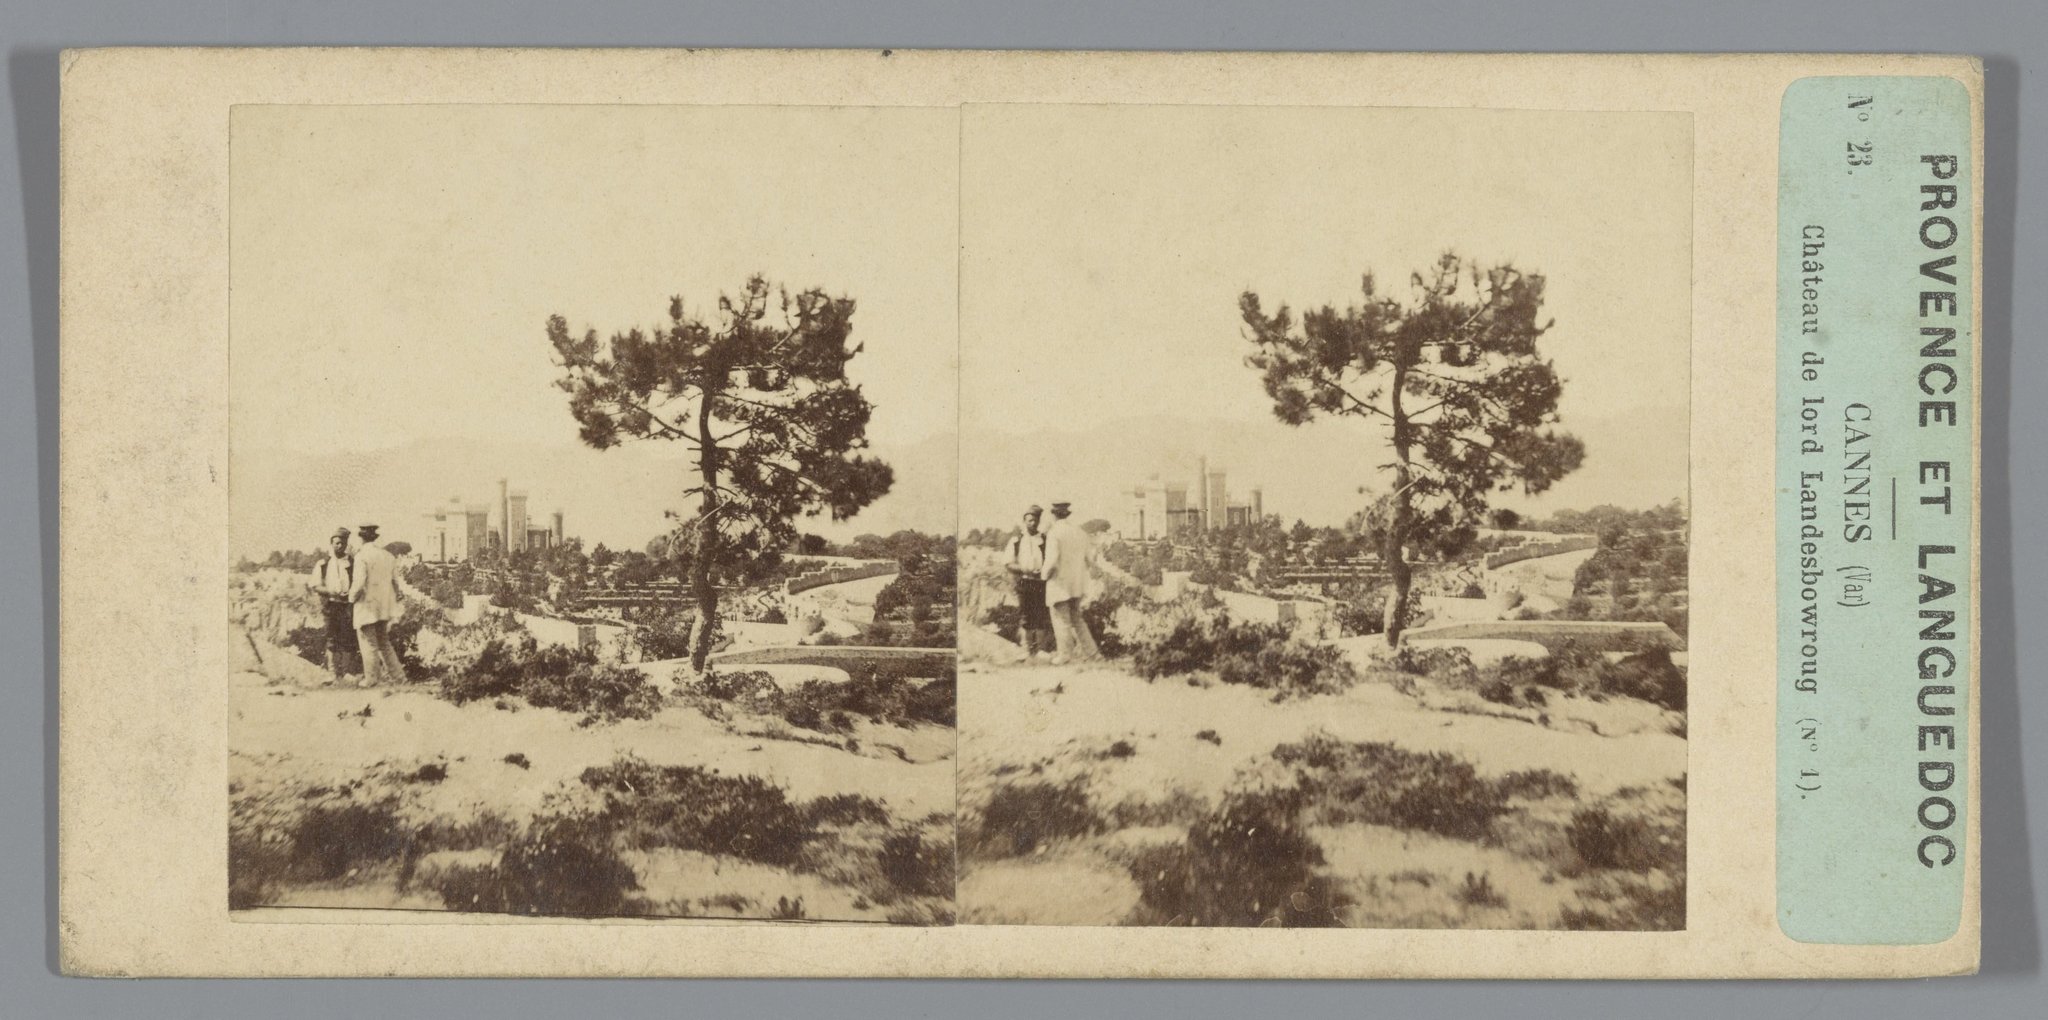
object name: stereograph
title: Provence et Languedoc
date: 1858-1860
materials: cardboard, photographic support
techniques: albumen print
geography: cannes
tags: castle, façade (of house or building)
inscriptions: number: ‘No 1’, inscription: ‘Furne fils et H. Tournier Rue de Seine, 57, a Paris’, number: ‘No 23.’